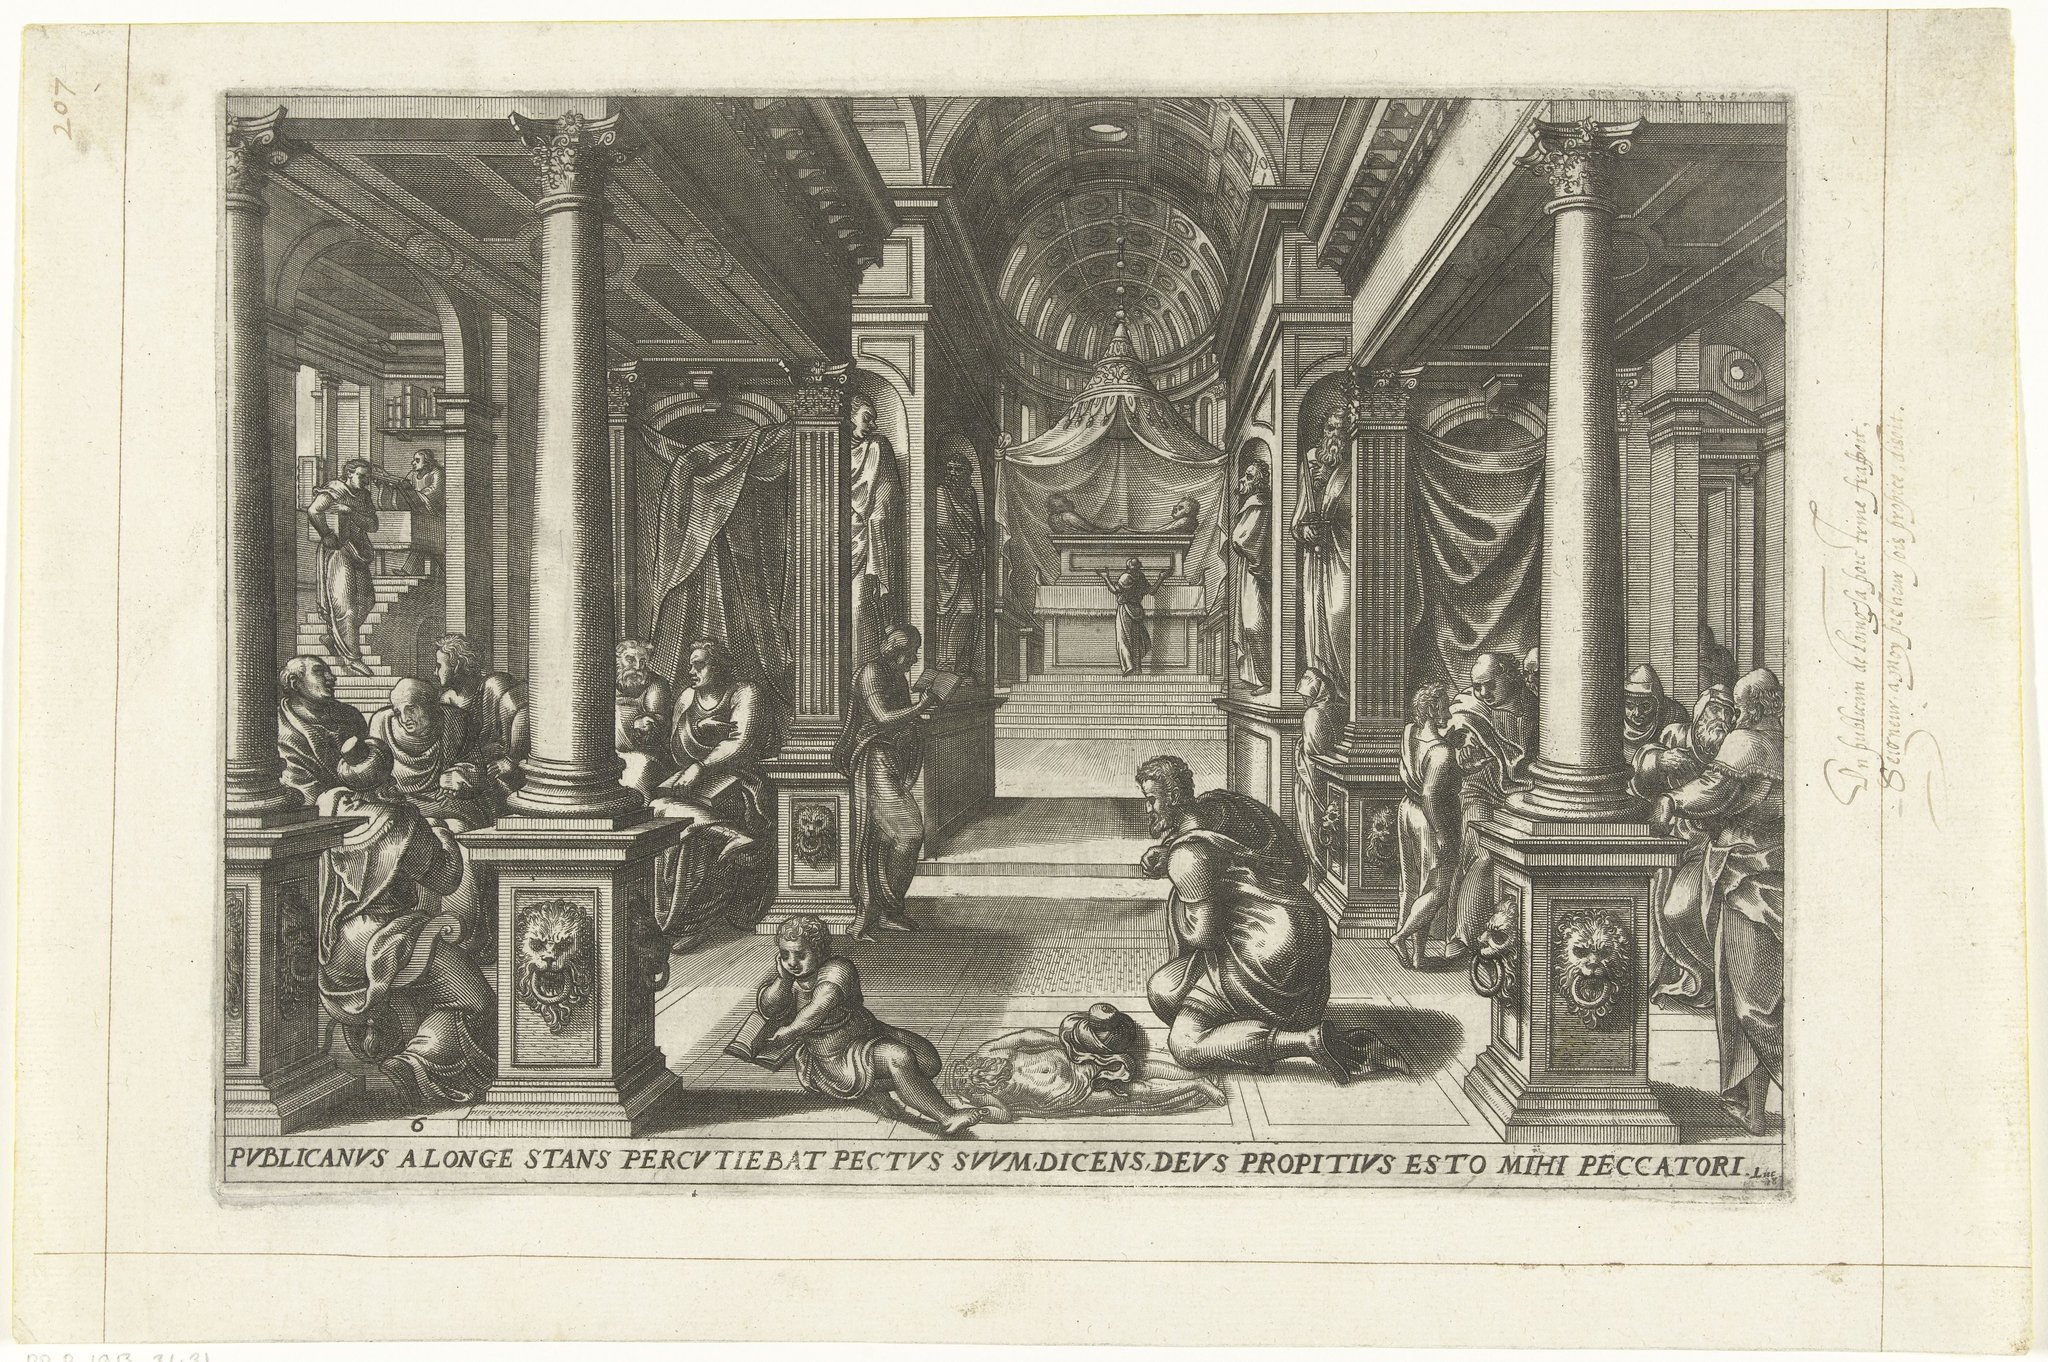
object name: print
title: De farizeër en de tollenaar in de tempel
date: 1572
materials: paper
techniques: engraving, etching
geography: antwerp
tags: the praying pharisee and the repentant publican in the temple (luke 18:10-14)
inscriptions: inscription: ‘Un publicain de loing sa porc trine frassoit [...]’, collector's mark: Lugt 2228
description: Een Farizeër bidt in de tempel bij het altaar. Op de voorgrond knielt een tollenaar. Hij durft niet dichtbij te komen en vraagt God om vergiffenis van zijn zonden. In de zijbeuken van de tempel zijn mensen druk in gesprek.